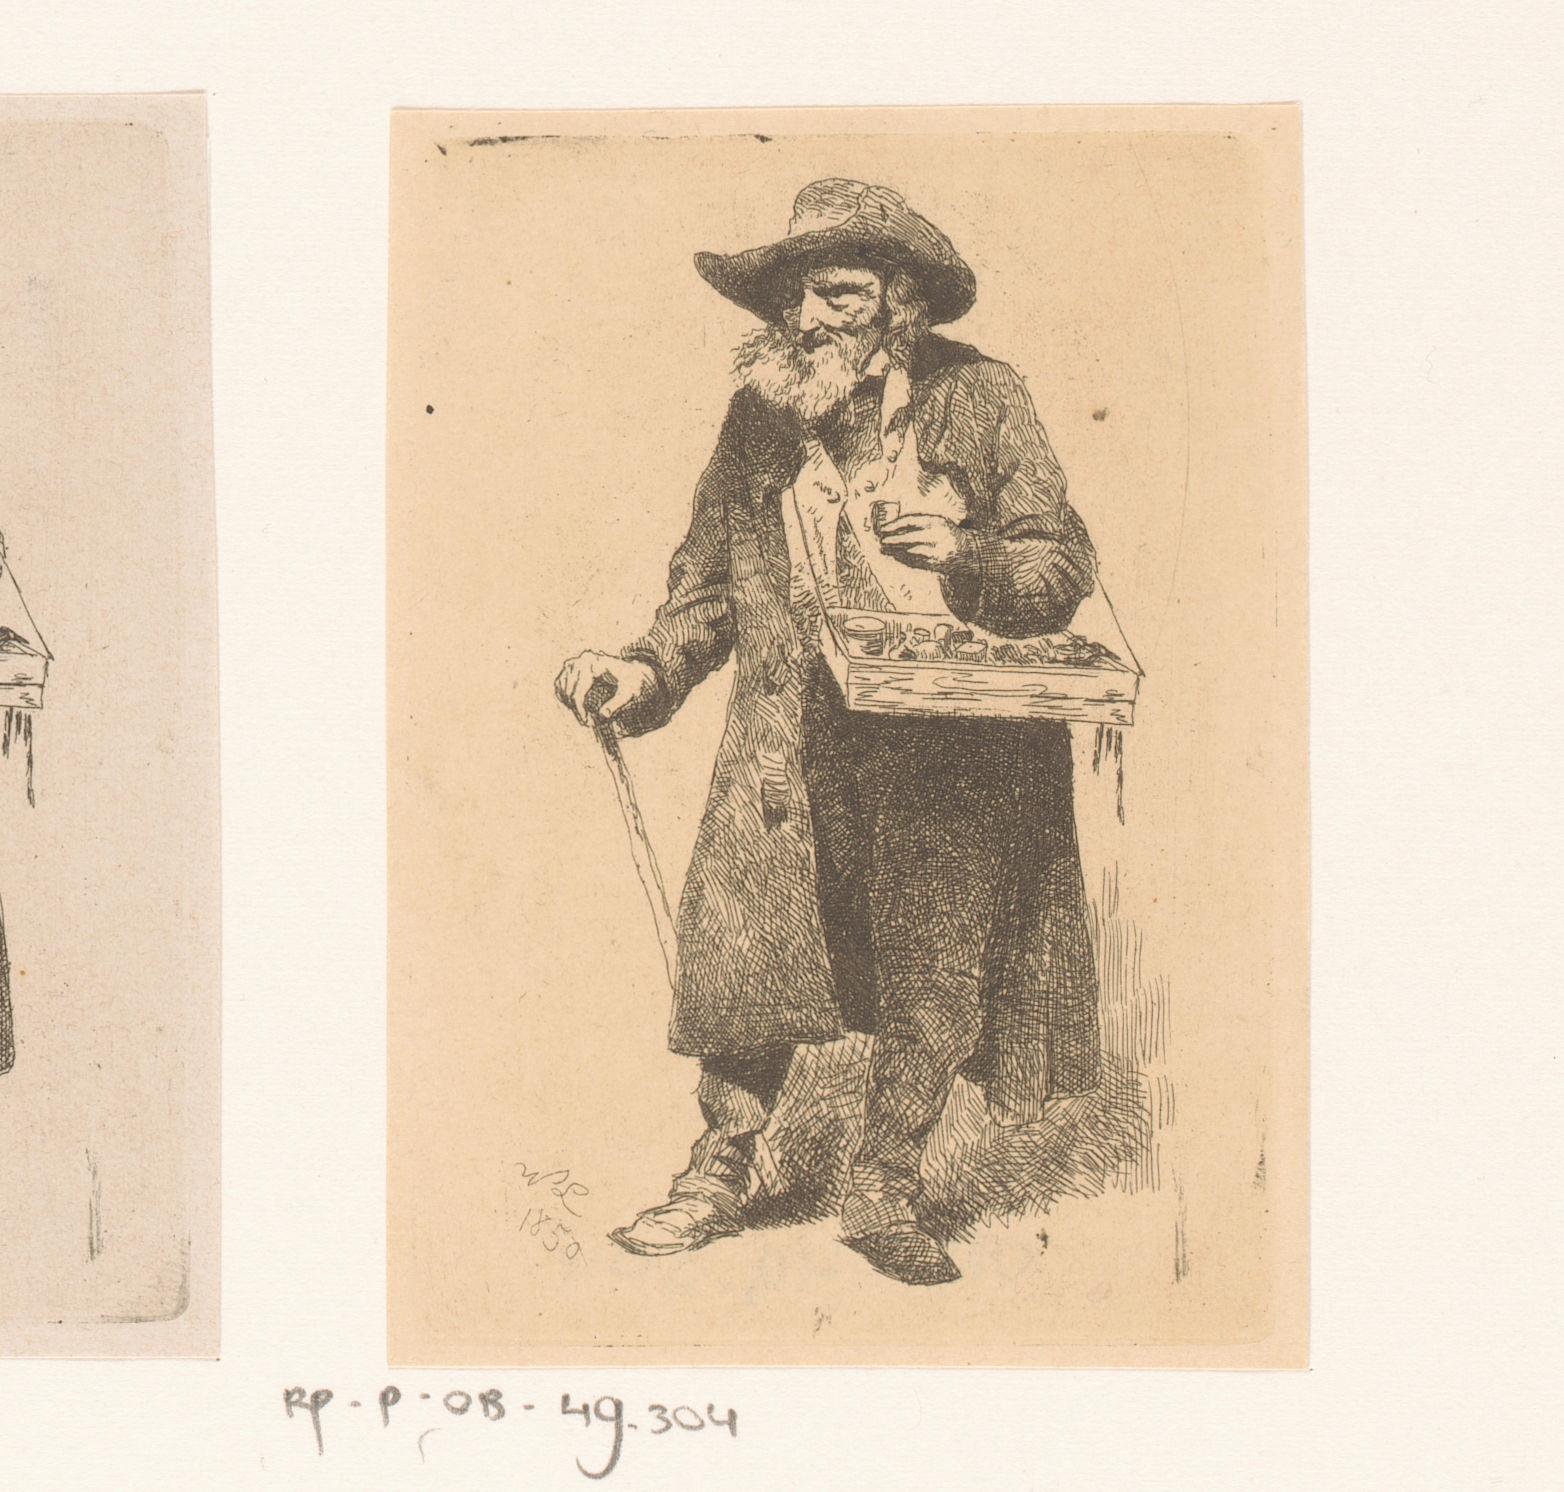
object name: print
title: Marskramer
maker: willem linnig (i)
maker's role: print maker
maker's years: 1819-1885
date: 1850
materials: paper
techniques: etching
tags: street-trader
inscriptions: collector's mark: Lugt 2228